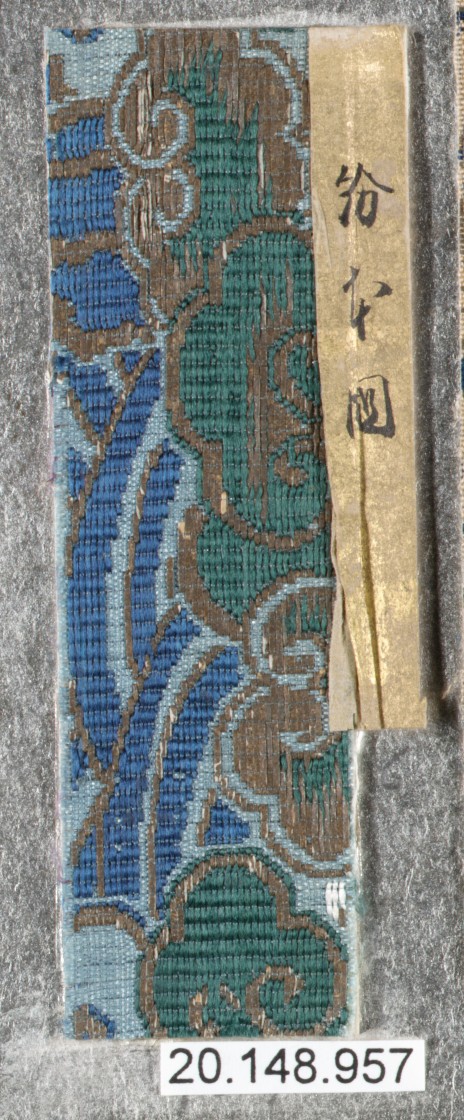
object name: piece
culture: japanese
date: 1701-1800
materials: silk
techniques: compound weave